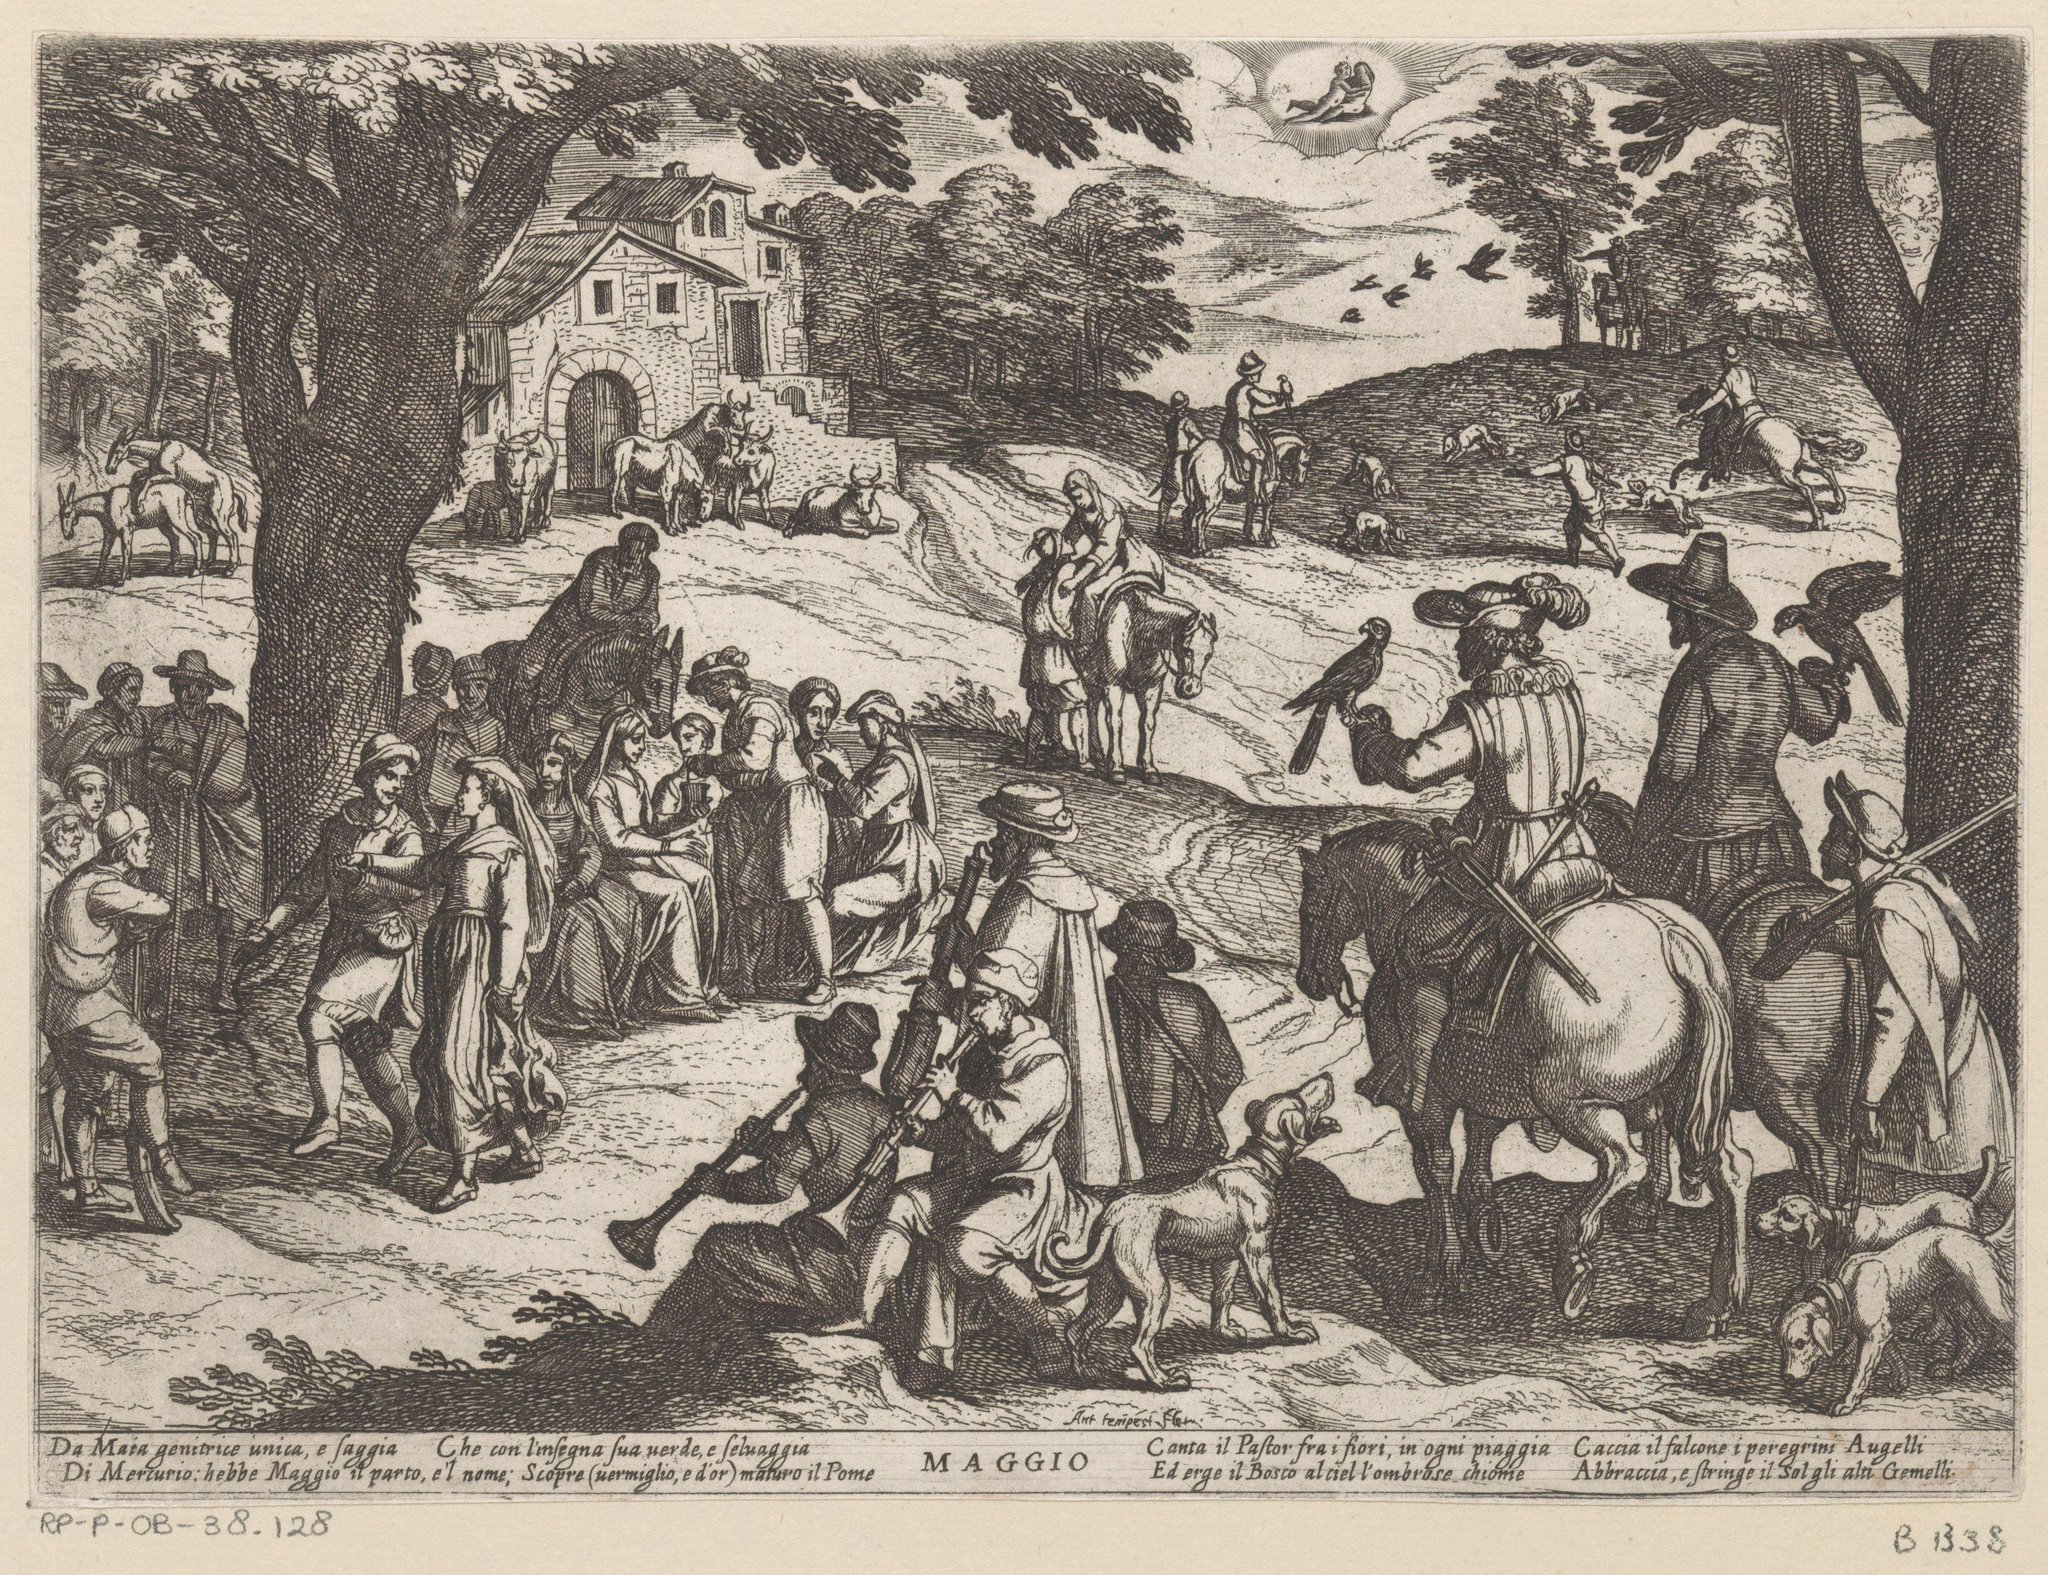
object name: print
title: De twaalf maanden (deel 1)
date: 1599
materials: paper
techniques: etching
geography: italy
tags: predatory birds: falcon, the twelve months represented by scenes showing human activities, usually in a landscape; so-called 'labours of the months', wedding feast, wedding meal, musician - cc - out of doors, hunters hunting (n.b.: in 1988-1990 this notation denoted the concept of 43c11421 'hunters resting during the hunt'), gemini (zodiacal sign of may)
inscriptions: collector's mark: Lugt 240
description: Verbeelding van menselijke activiteit in de maand mei. Landschap met jagers jagend met behulp van valken. Op de voorgrond links een boerenbruiloft en muzikanten. Midden boven het symbool voor het sterrenbeeld tweelingen. Italiaans vers en titel in ondermarge.